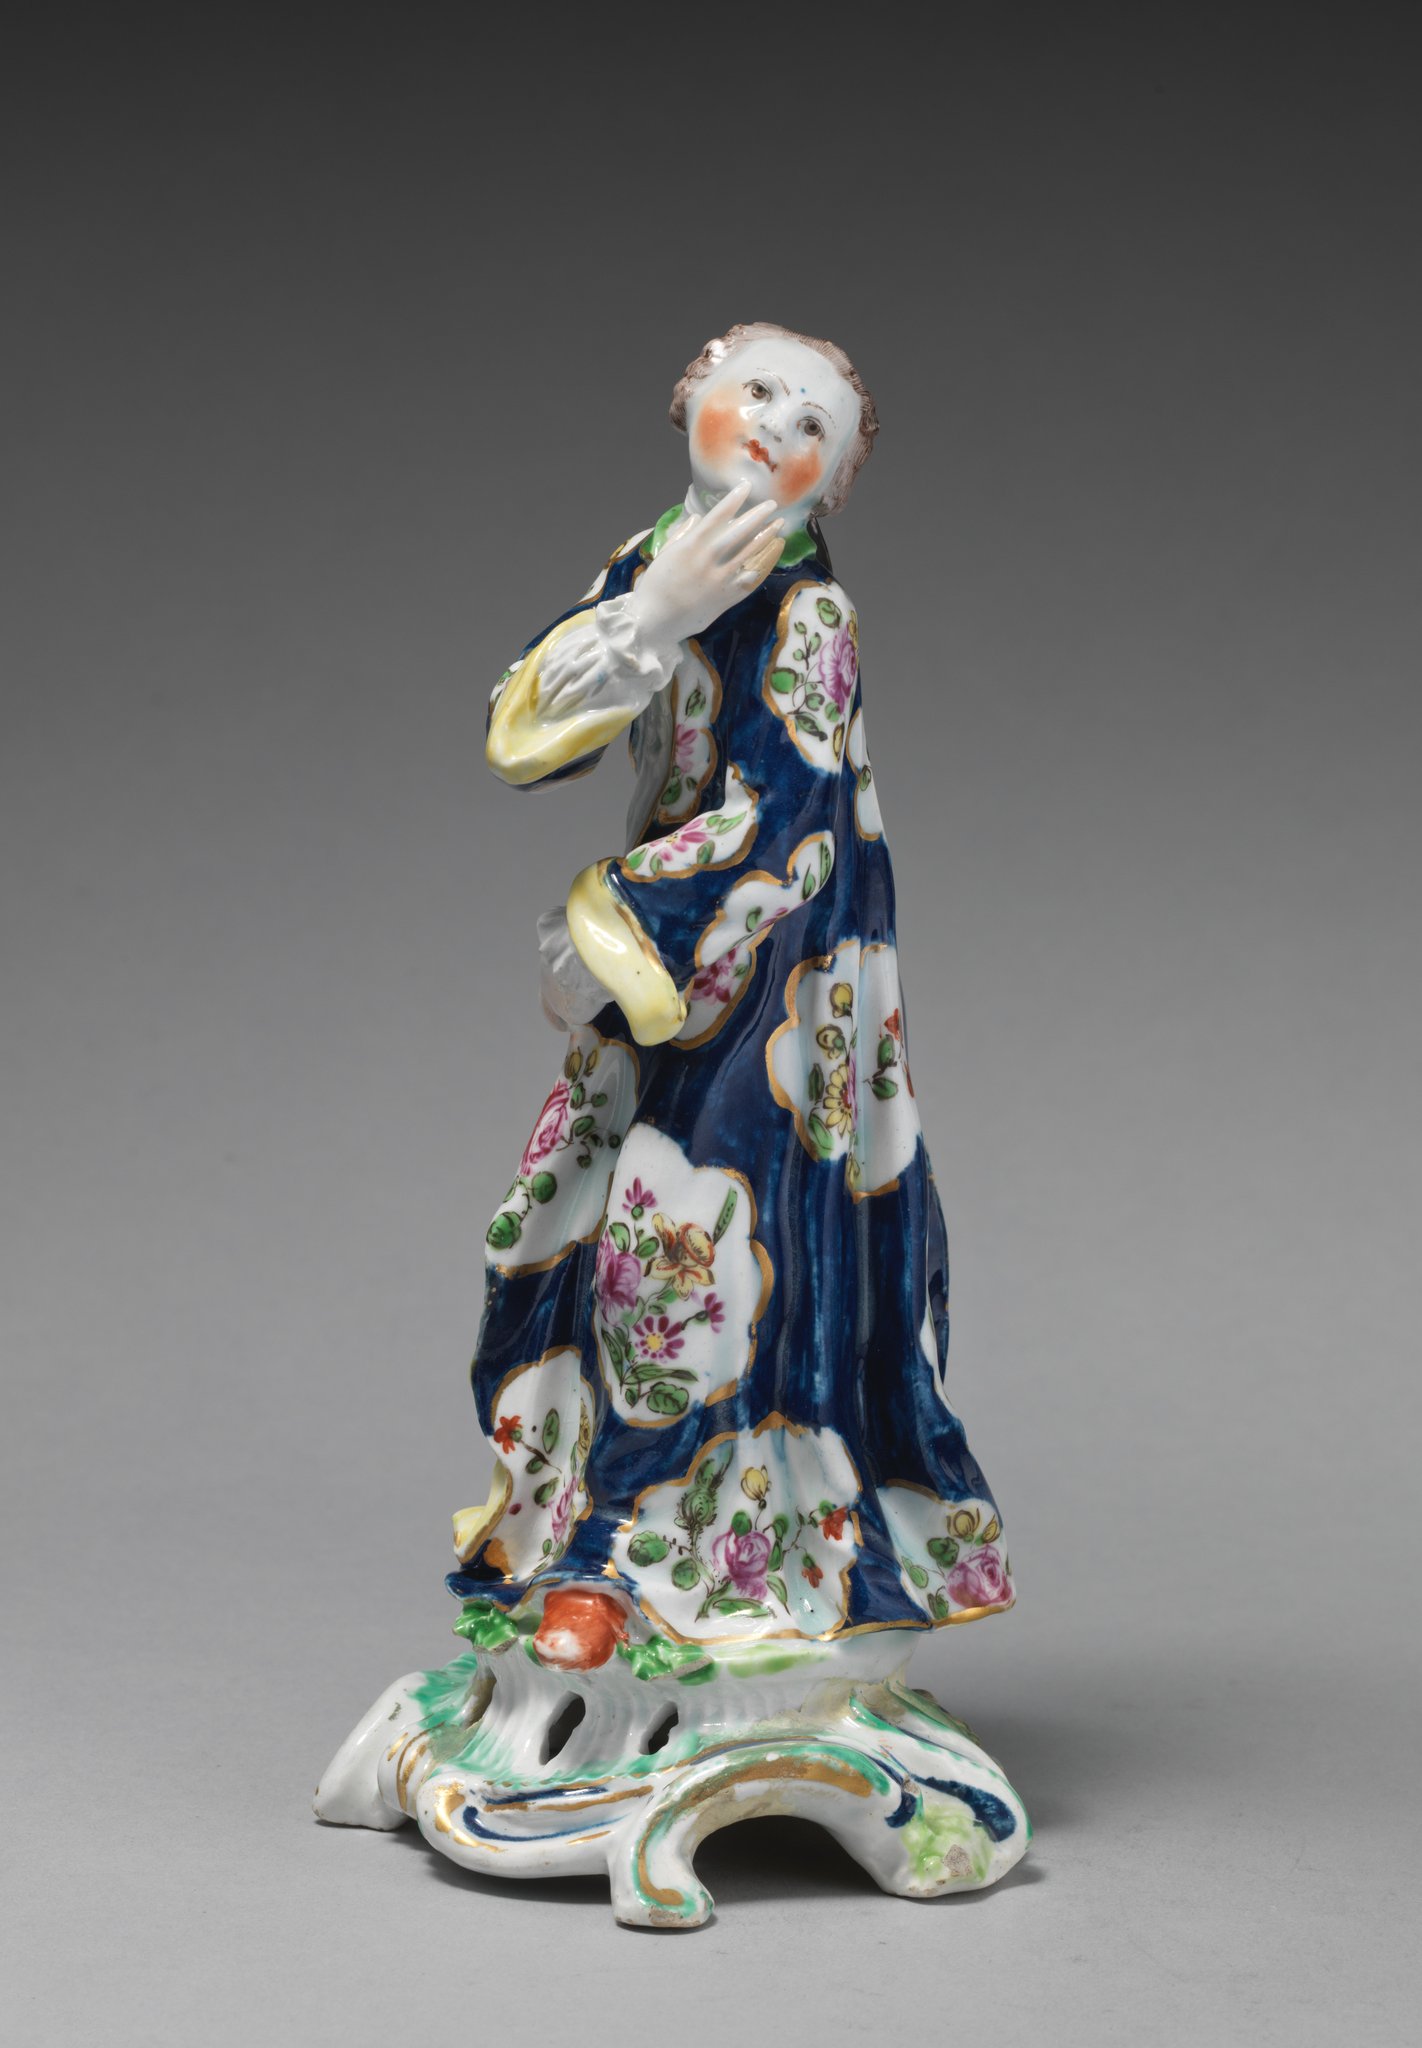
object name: figure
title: The Thrown Kiss (one of a pair)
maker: bow porcelain factory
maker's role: factory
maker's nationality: british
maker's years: 1747-1776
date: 1765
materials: soft paste porcelain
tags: men